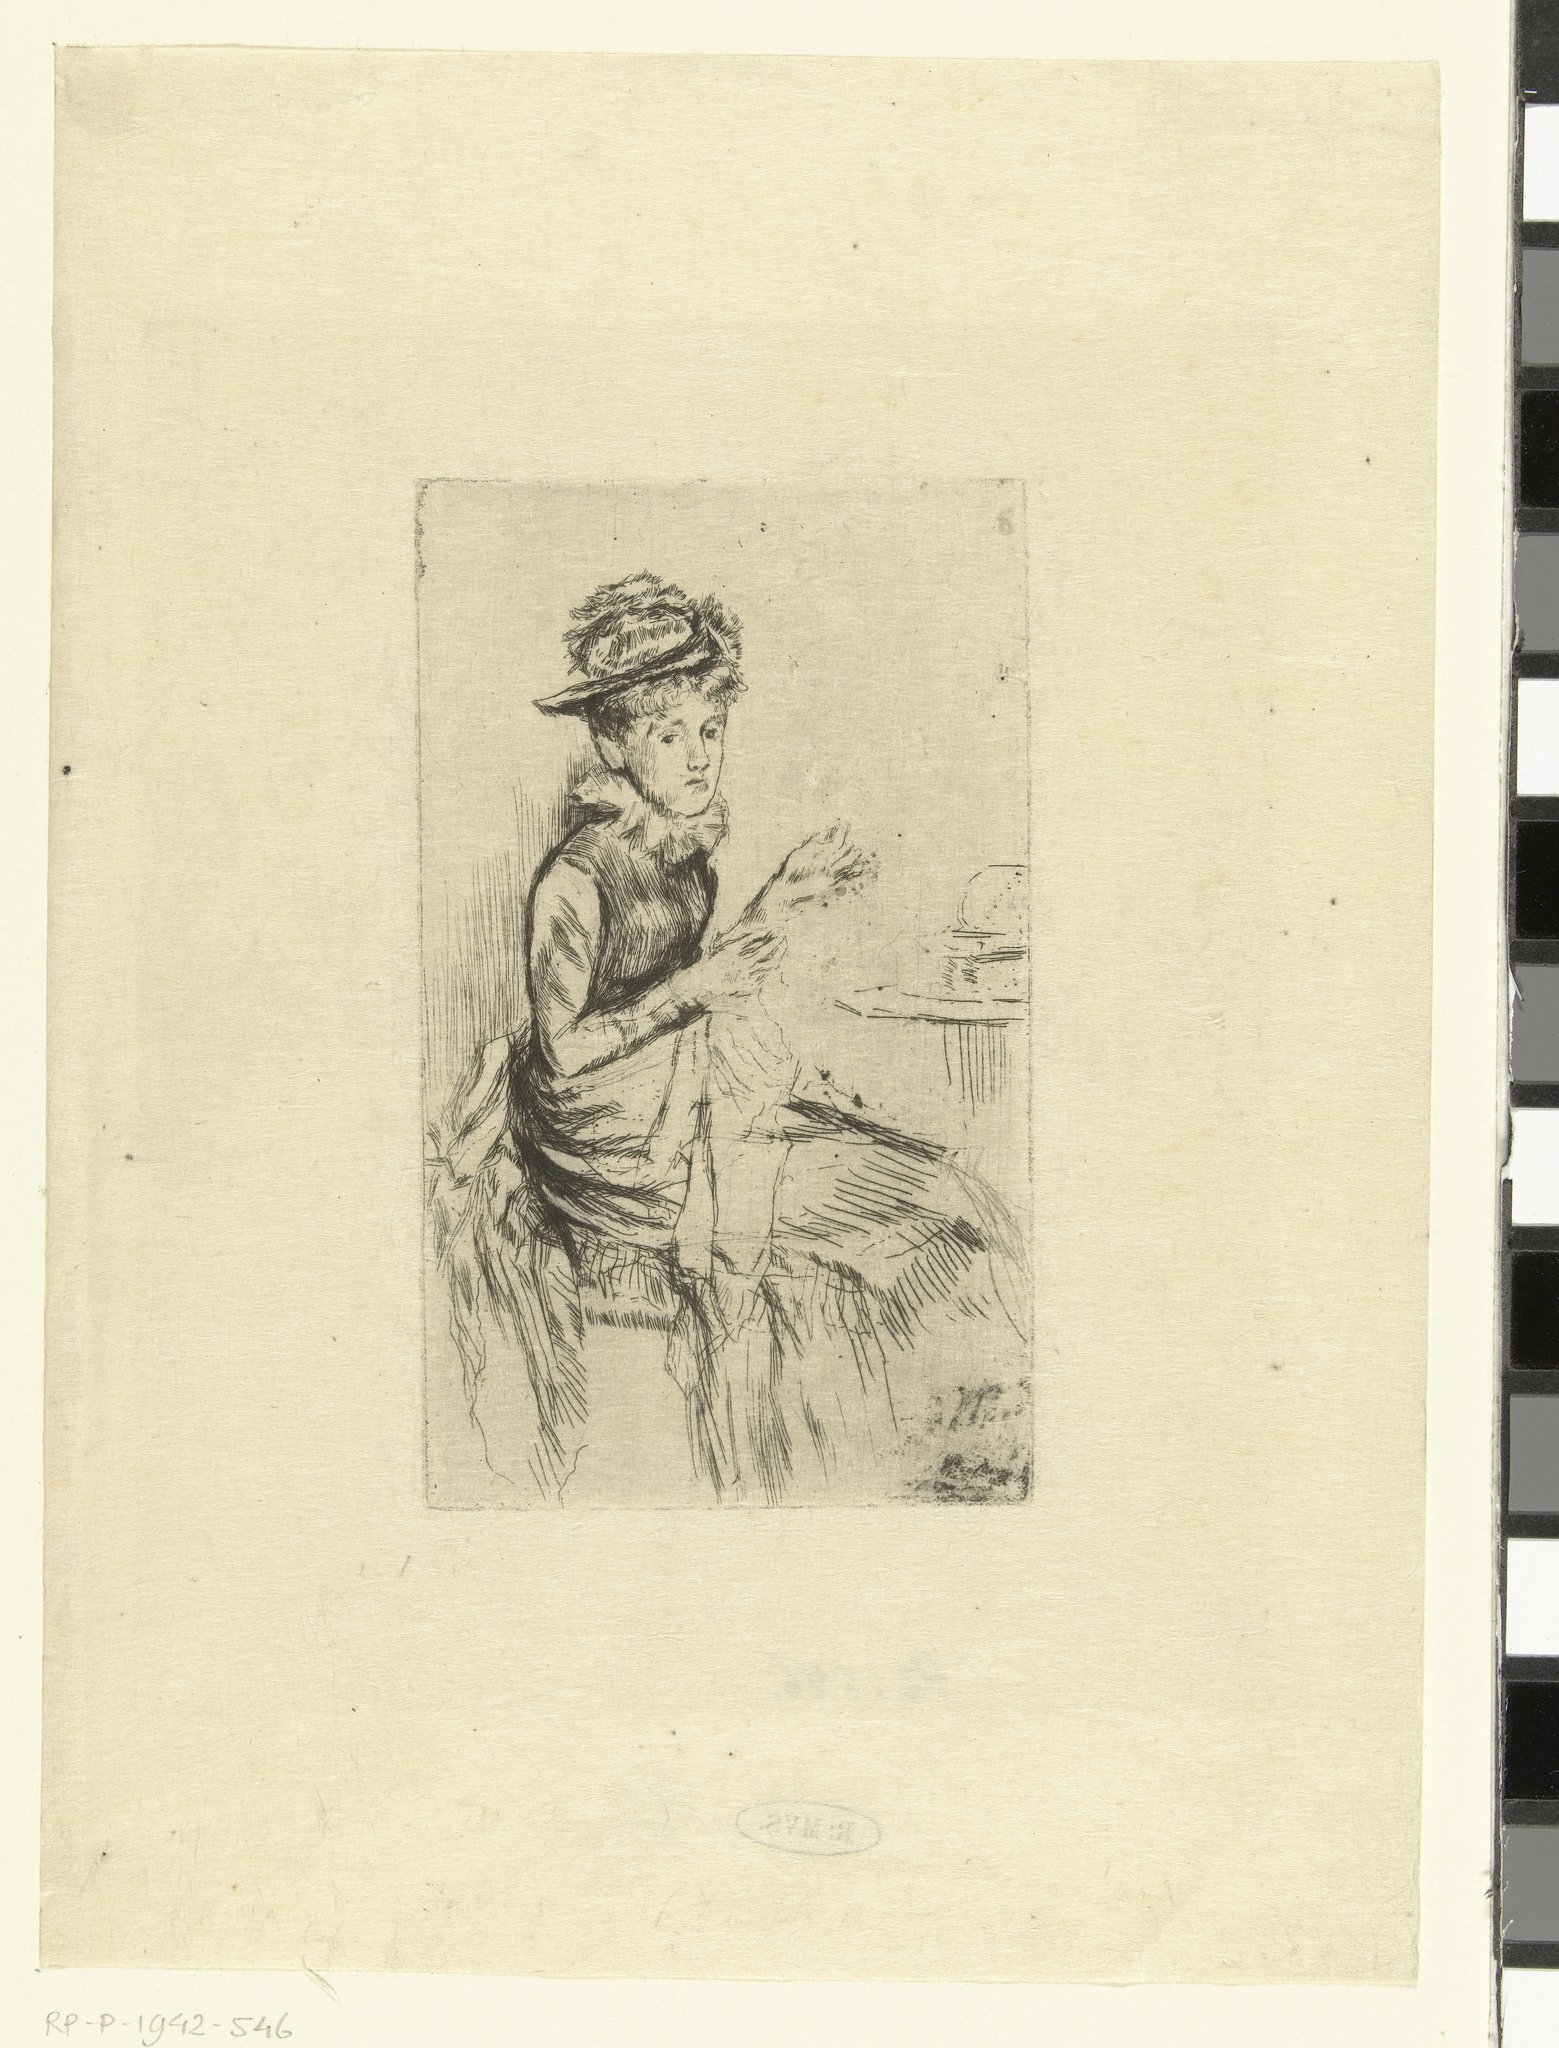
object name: print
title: Vrouw bezig met handwerken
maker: james abbott mcneill whistler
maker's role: painter, print maker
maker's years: 1834-1903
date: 1873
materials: paper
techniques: drypoint, etching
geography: england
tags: (other forms of) needlework, e.g.: crocheting, knitting, embroidering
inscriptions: collector's mark: Lugt 1376, collector's mark: Lugt 2228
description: Jonge vrouw zittend bij een tafel, handwerk op haar schoot en een draad in haar handen.